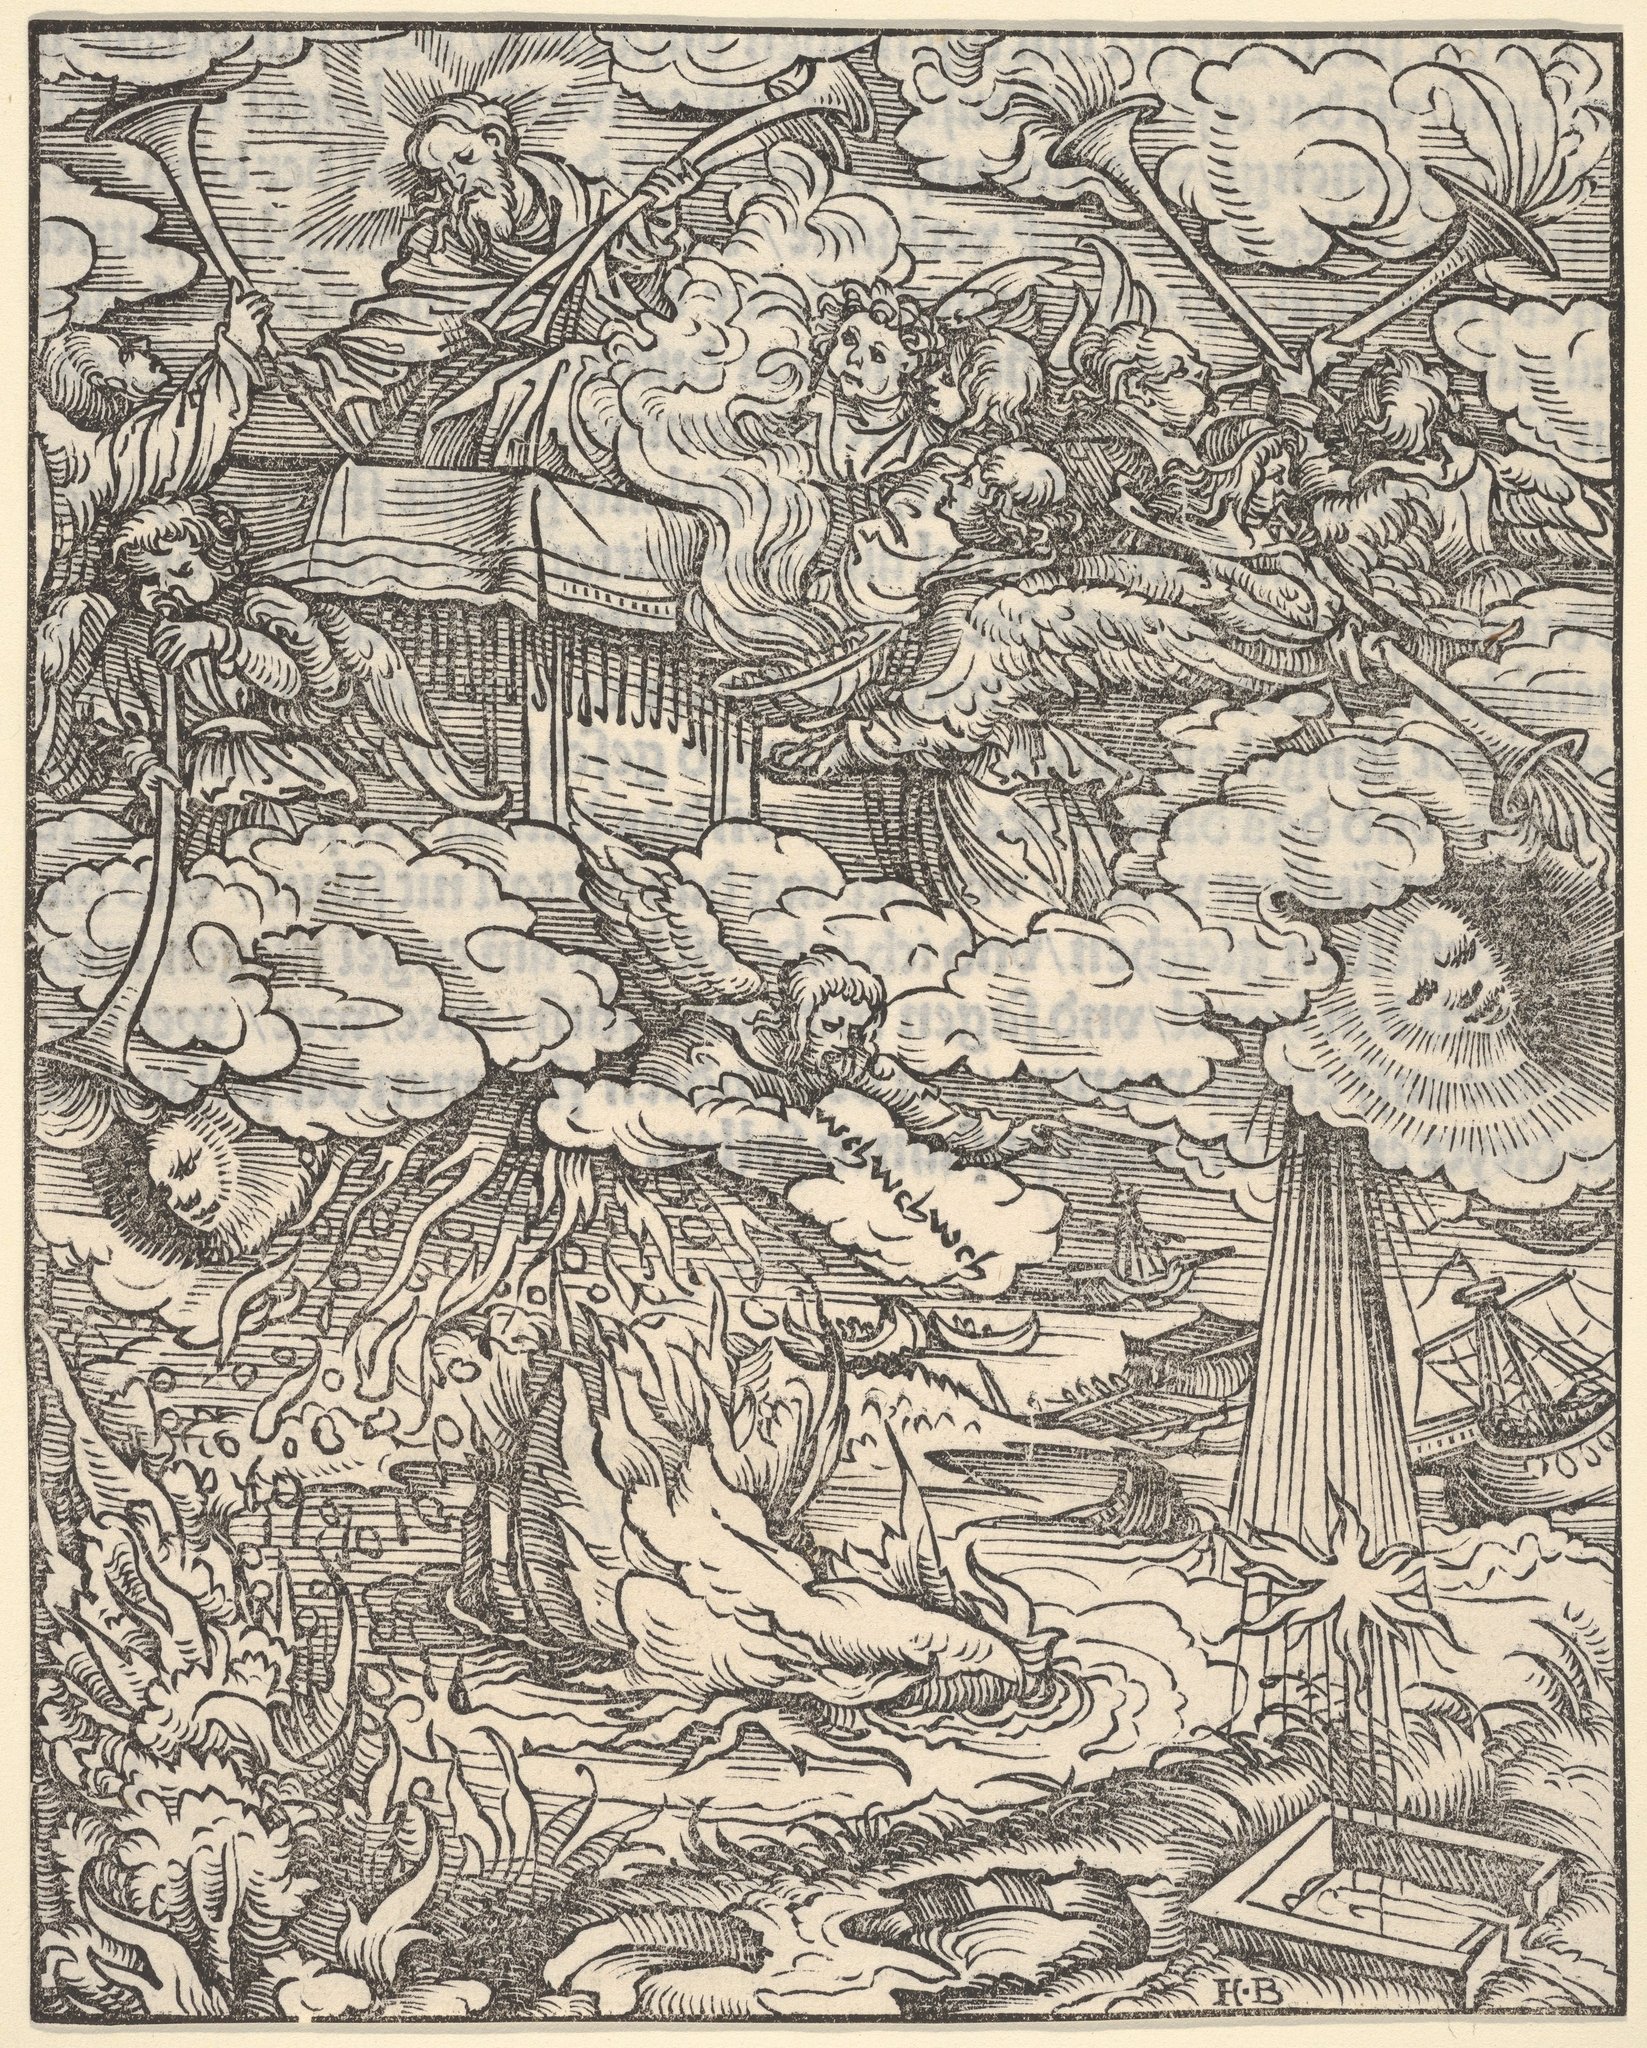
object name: print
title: The First Four Trombones, plate 7 from The Apocalypse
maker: hans burgkmair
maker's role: artist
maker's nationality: german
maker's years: 1473-1531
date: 1523-1524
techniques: woodcut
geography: germany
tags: trombones,apocalypse